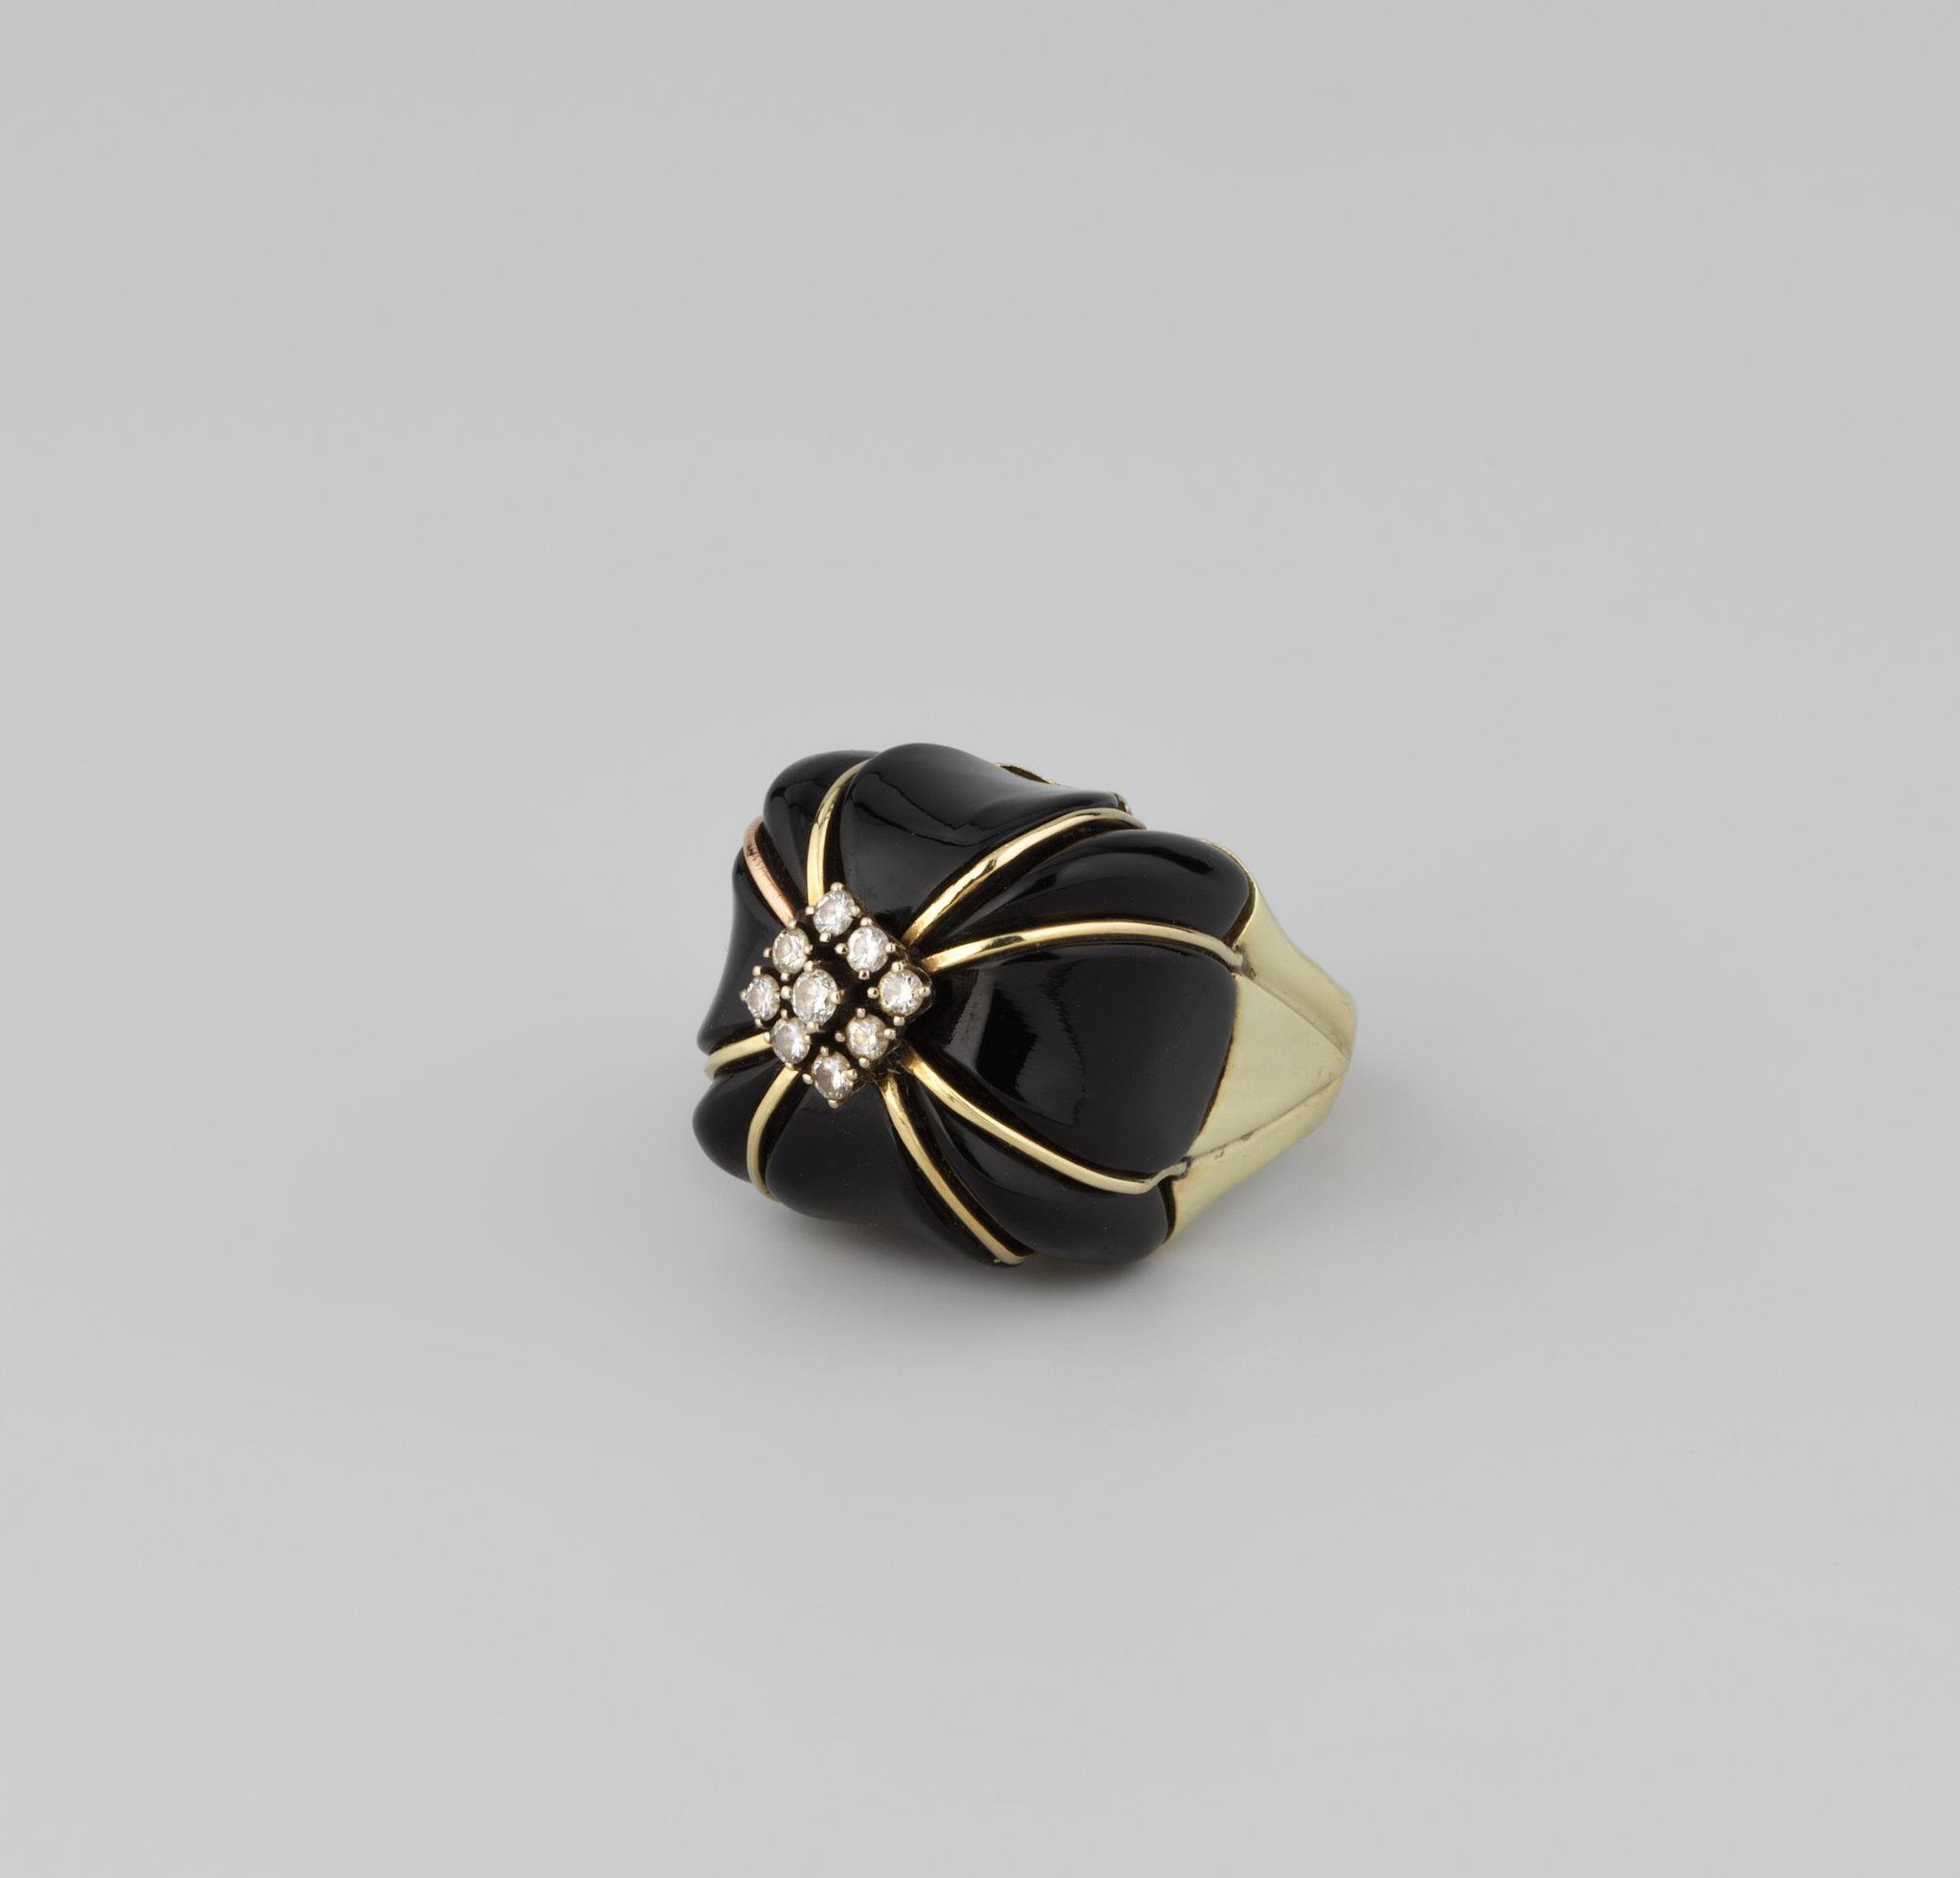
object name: ring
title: Cocktailring van goud, onyx met diamant en zwart gelakte ornamenten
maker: Anonymous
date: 1950-1955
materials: diamond, gold, lacquer, onyx, gold alloy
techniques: grinding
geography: united states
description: Geelgouden cocktailring met negen diamanten in briljantslijpsel in vierpootchatons van witgoud, onyx en zwart gelakte ornamenten die afwisselend convex en concaaf zijn. Geen verantwoordelijkheidstekens.